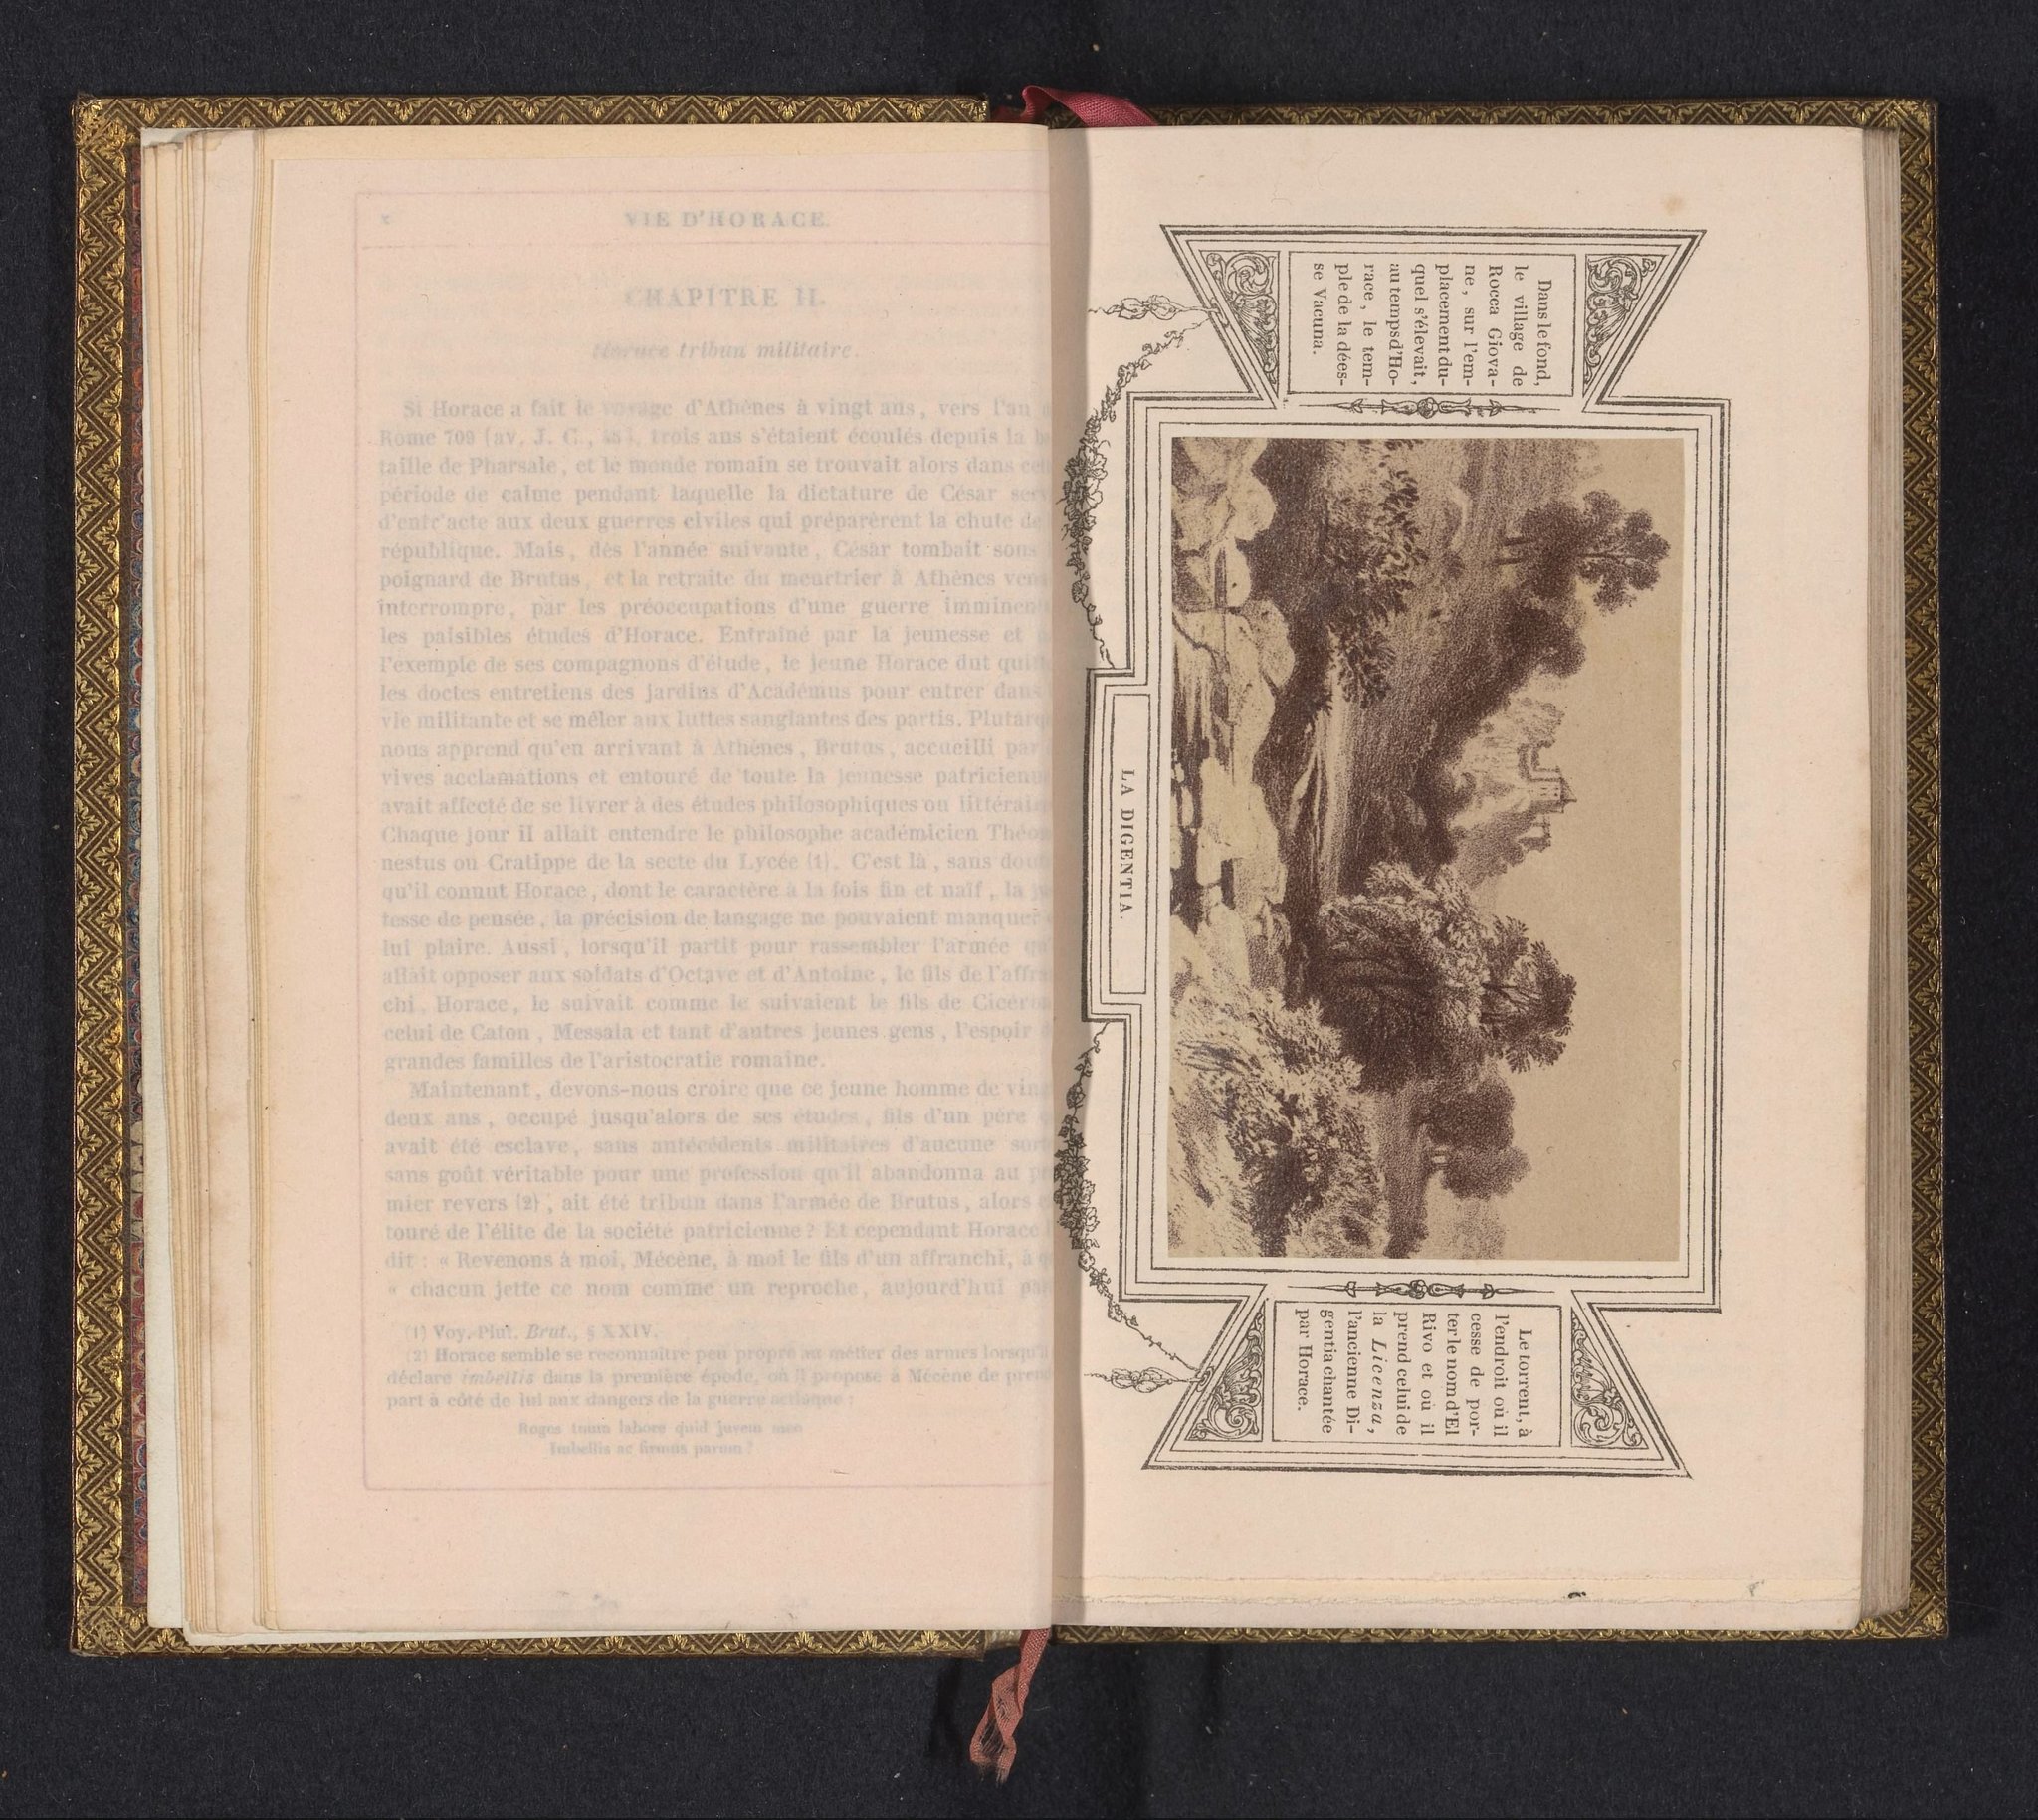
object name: photograph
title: Fotoreproductie van een tekening, voorstellende een gezicht op Licenza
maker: Anonymous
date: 1850-1855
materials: photographic support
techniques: albumen print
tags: city-view in general; 'veduta'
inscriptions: inscription: ‘Dans le fond (...) par Horace.’